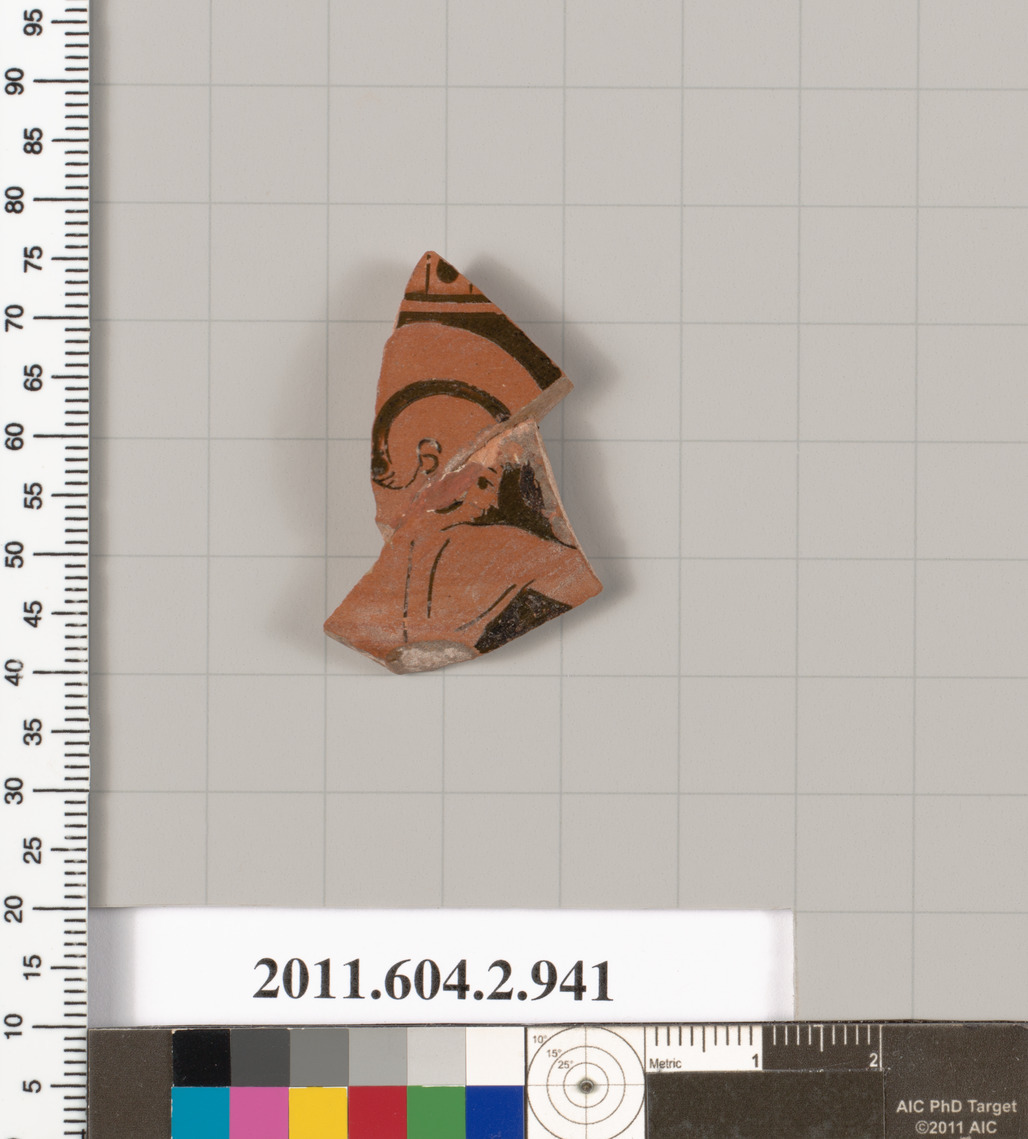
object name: oinochoe fragment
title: Terracotta fragment of an oinochoe (jug)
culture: greek, attic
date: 500-480 BCE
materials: terracotta